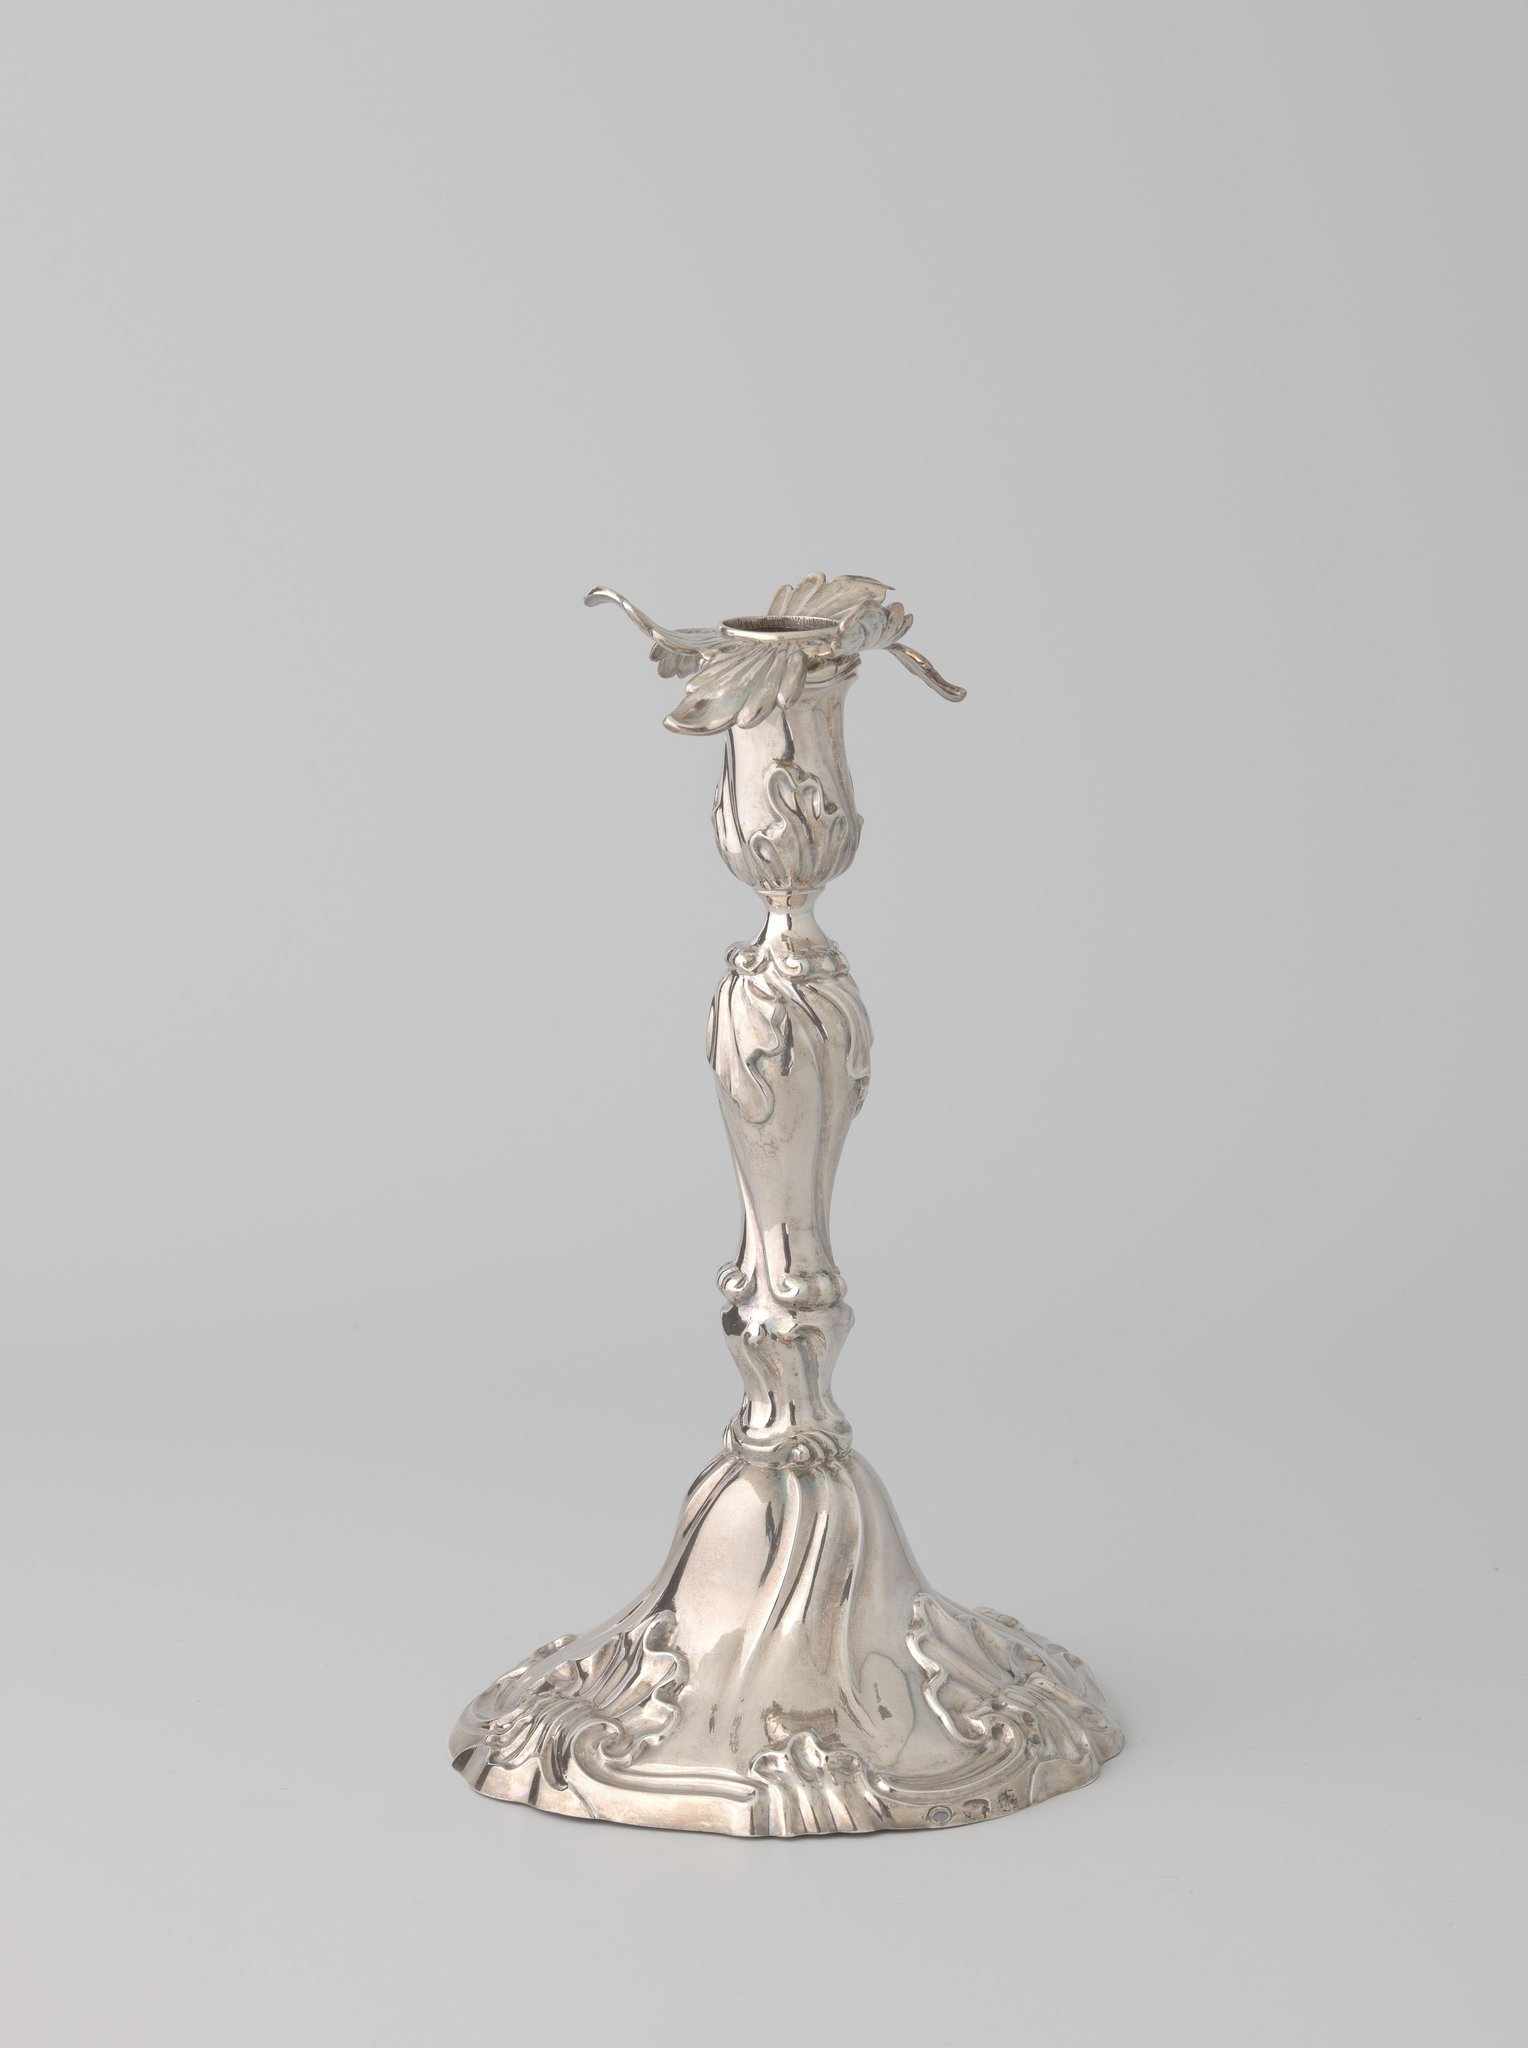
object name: candlestick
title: Kandelaar van zilver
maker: cornelius wilhelmus rensing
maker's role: silversmith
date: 1770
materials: silver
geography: zwolle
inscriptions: mark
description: Wine cooler. Silver. Den Haag, 1768, by Gregorius van der Toorn. Given by the Commissie voor Fotoverkoop and the Vereniging Rembrandt, 1974. Four candlesticks. Silver. Zwolle, 1770, by Cornelis Wilhelmus Rensing. Given by Count J.A.Z. van Rechteren Limpurg, 1937. Castor. Silver. Den Haag, 1768, by Pieter Kersbergen.